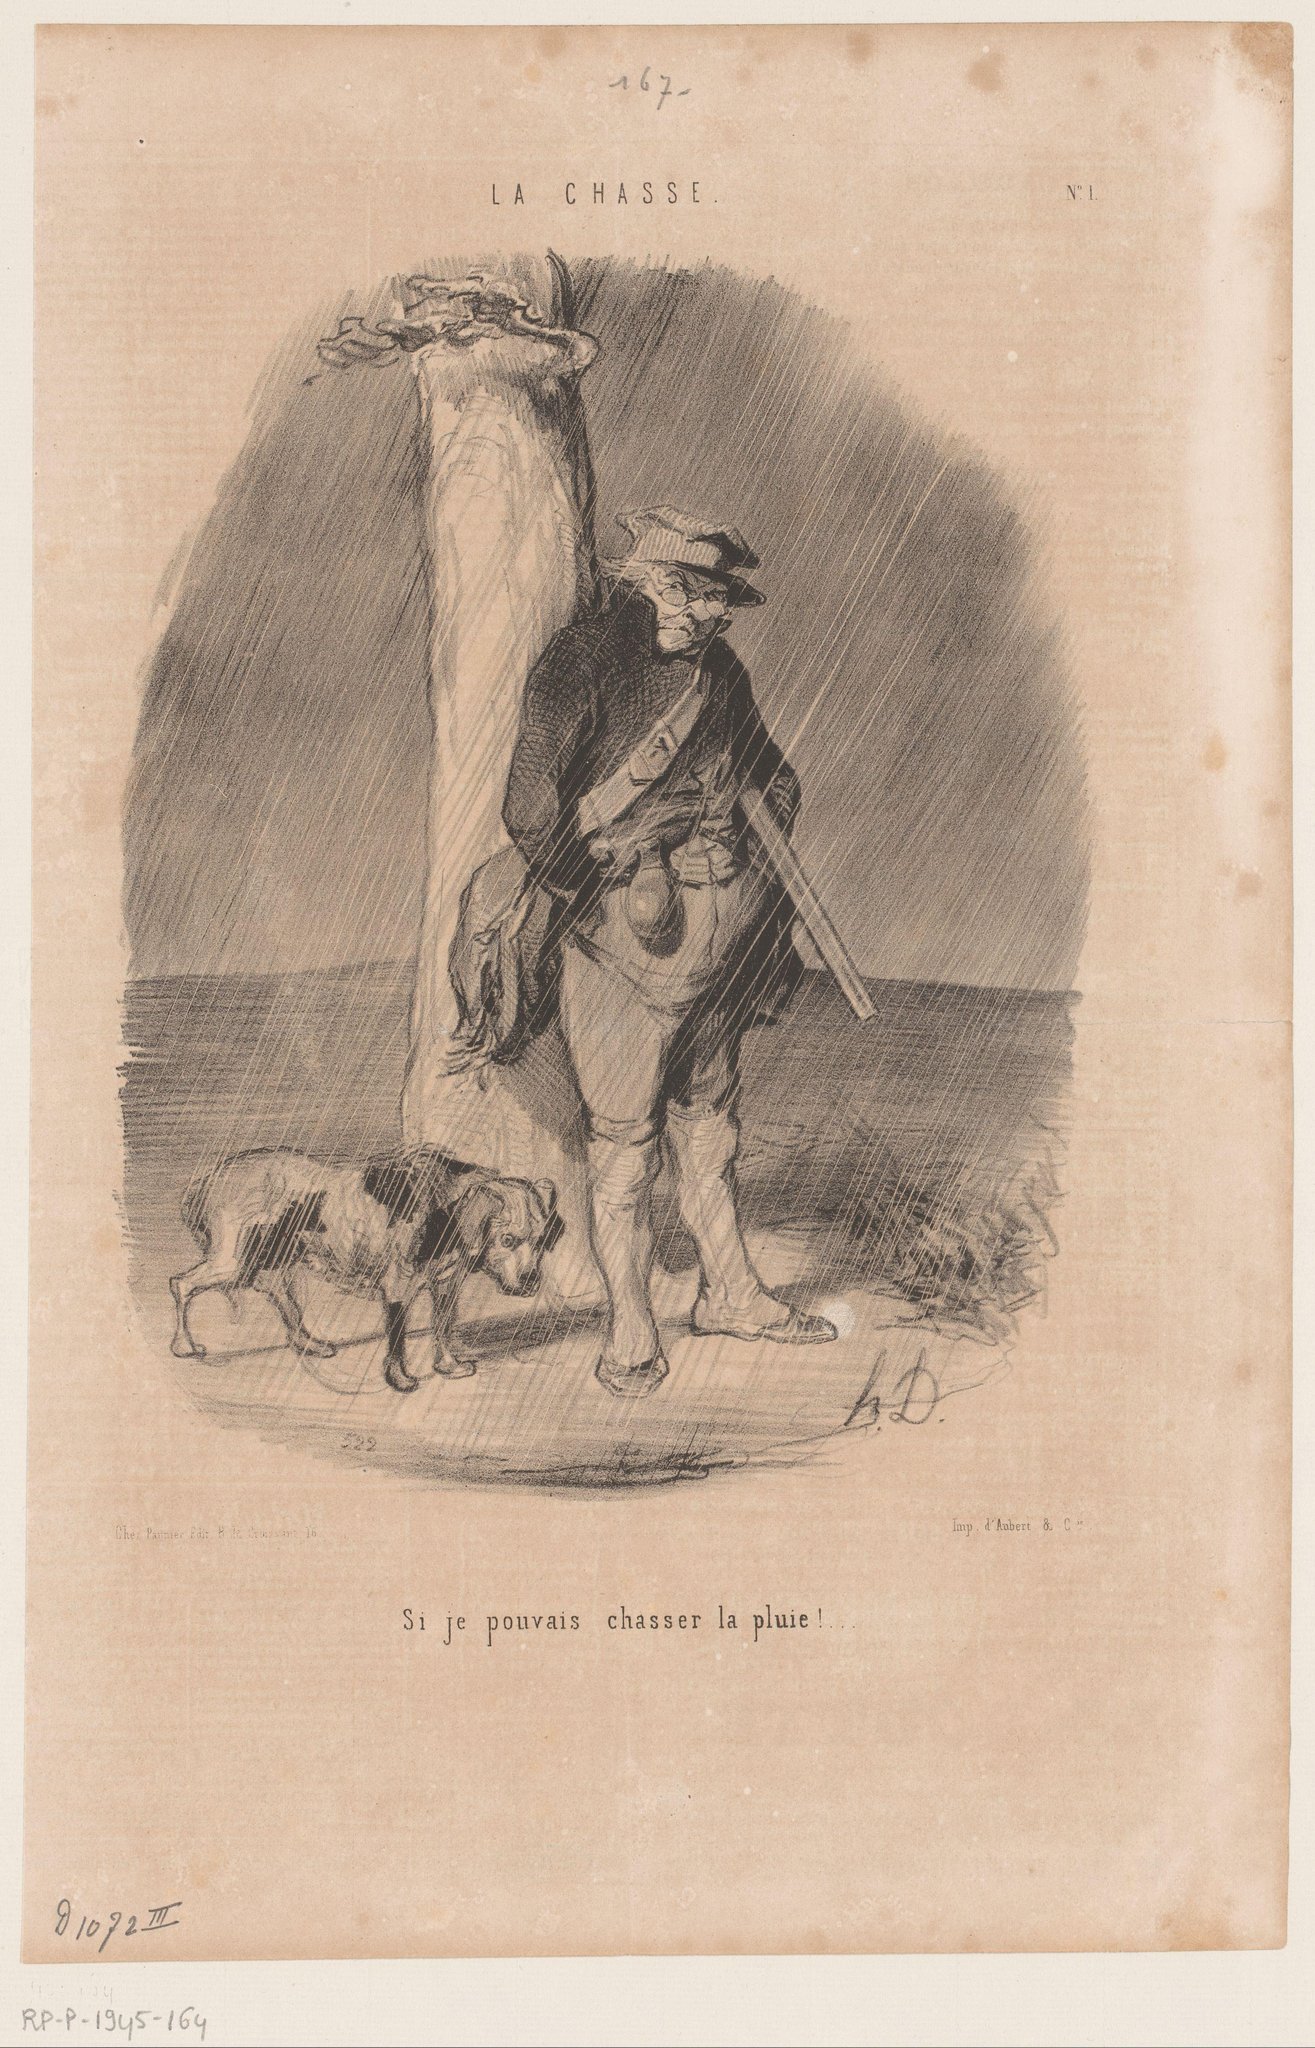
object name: cartoon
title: Jachtscènes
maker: honoré daumier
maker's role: draughtsman, painter, print maker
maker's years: 1808-1879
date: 1843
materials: paper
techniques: lithograph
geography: paris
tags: caricatures (human types), hunter, rain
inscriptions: number: ‘167’, collector's mark: Lugt 2228a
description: Prent gepubliceerd in: Le Charivari, Aubert: Parijs, 24-09-1843. Le Charivari was een humoristische krant met karikaturen en (politieke) cartoons.